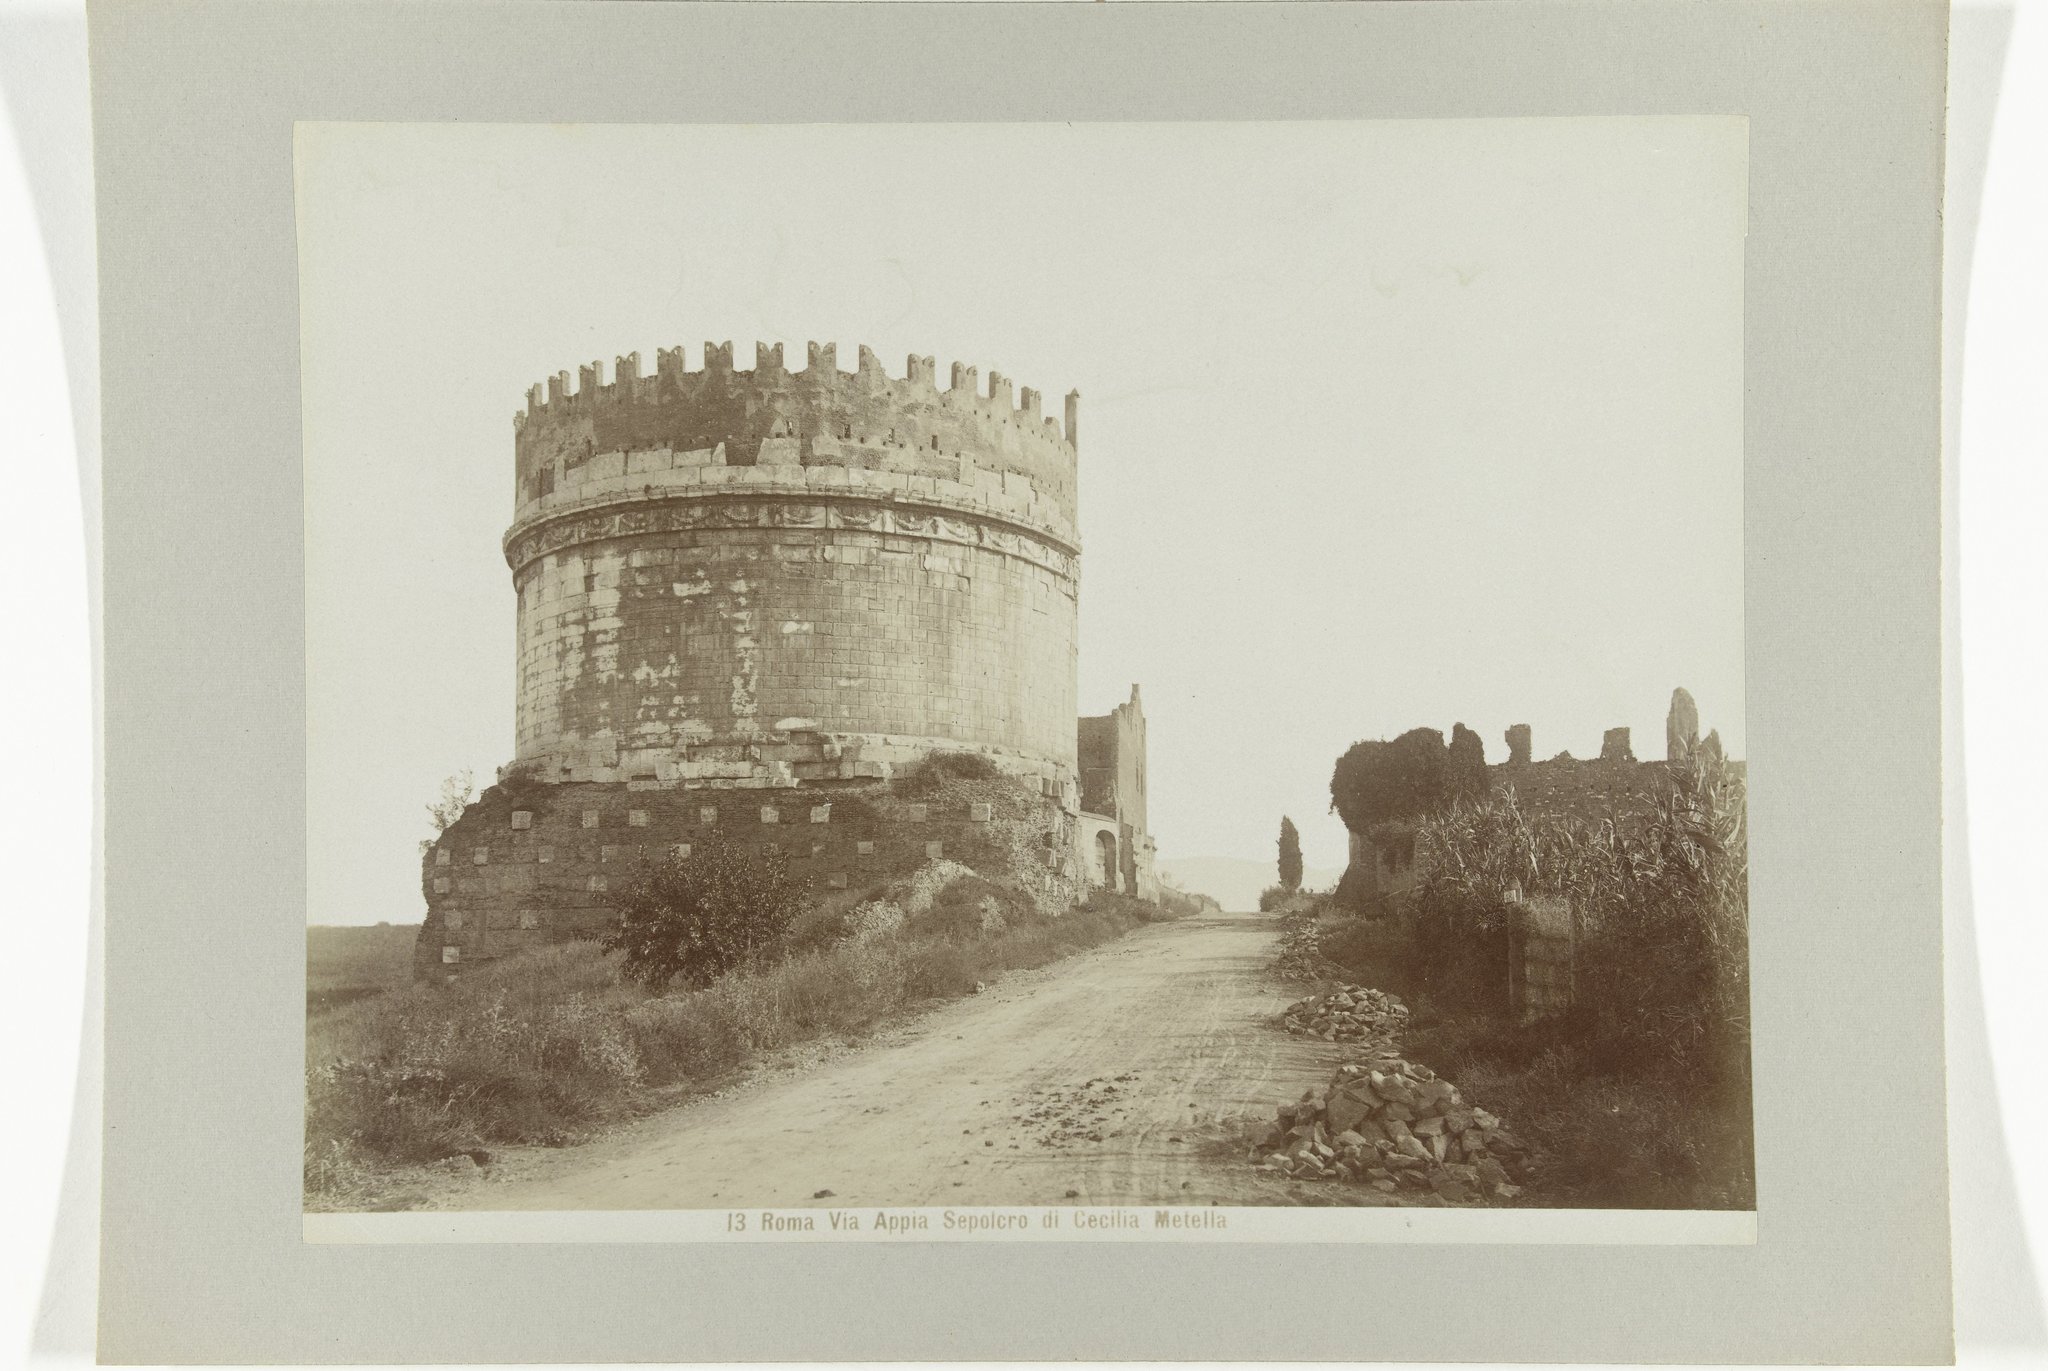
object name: photograph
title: Tombe van Caecilia Metella aan de Via Appia, Rome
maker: Anonymous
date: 1880-1904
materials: cardboard, paper, photographic support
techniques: albumen print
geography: rome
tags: tombe van caecilia metella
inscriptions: number: ‘24.’